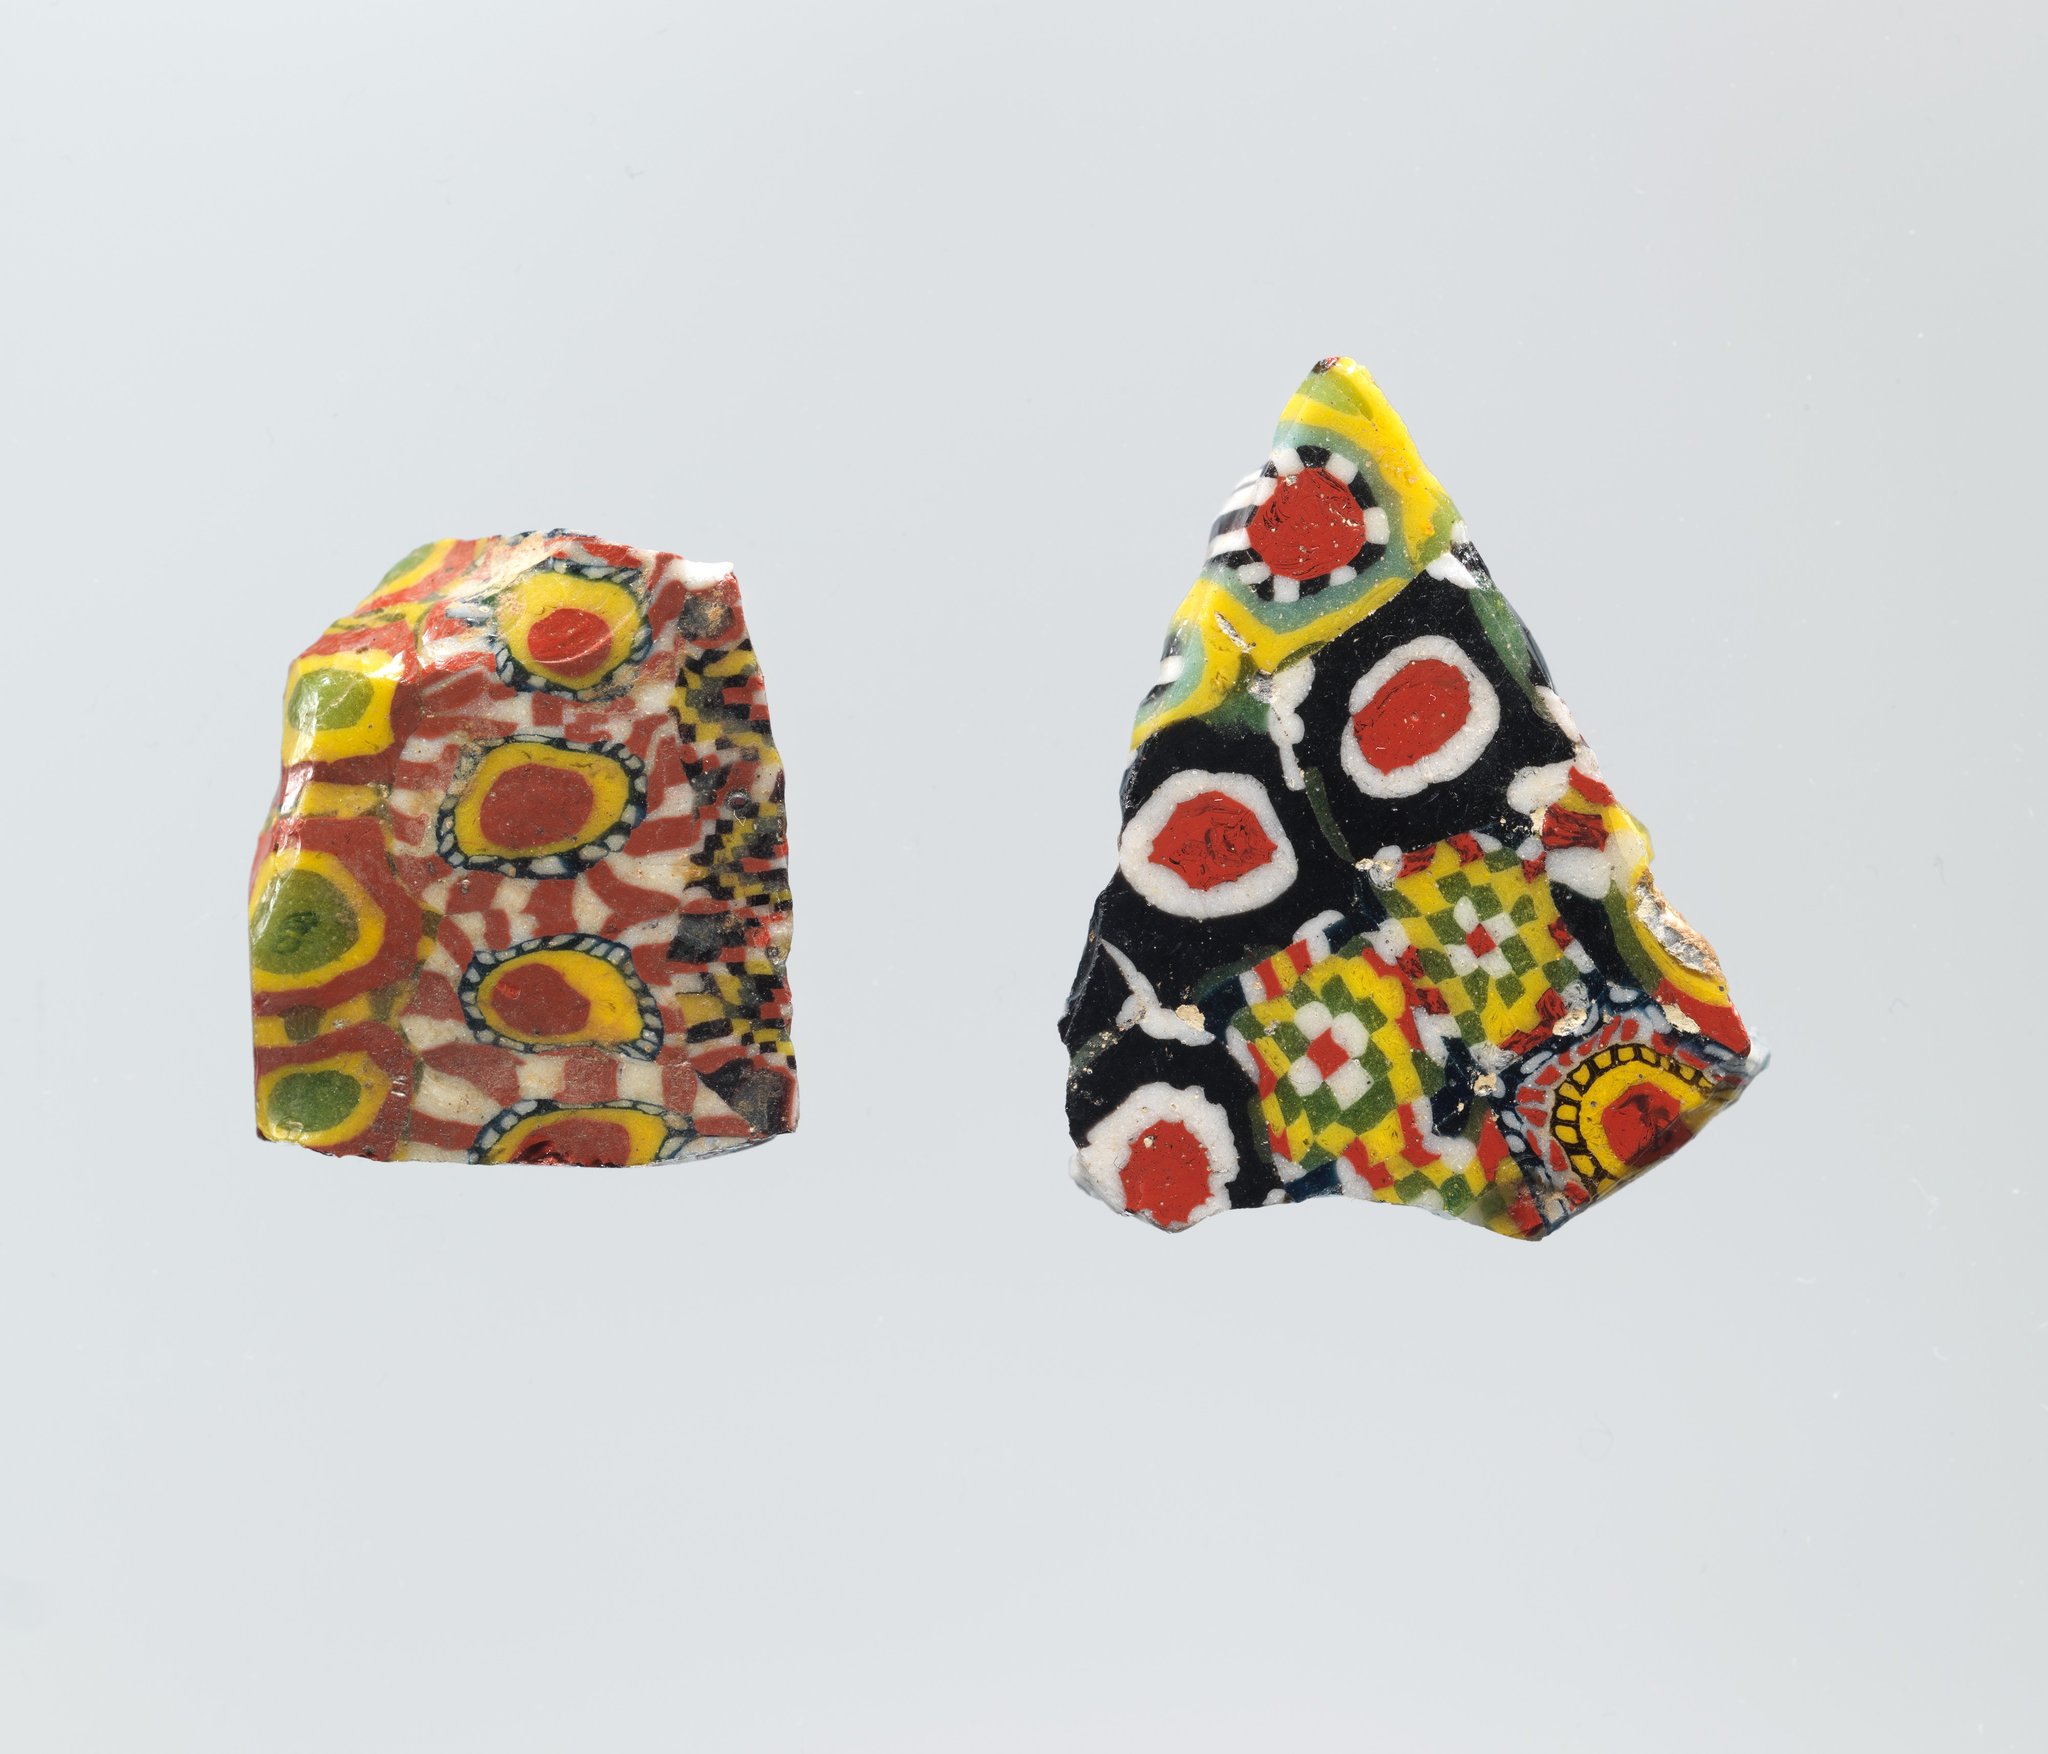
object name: glass fragment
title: Millefiori Glass Tile Fragments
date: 801-900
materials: glass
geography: iraq